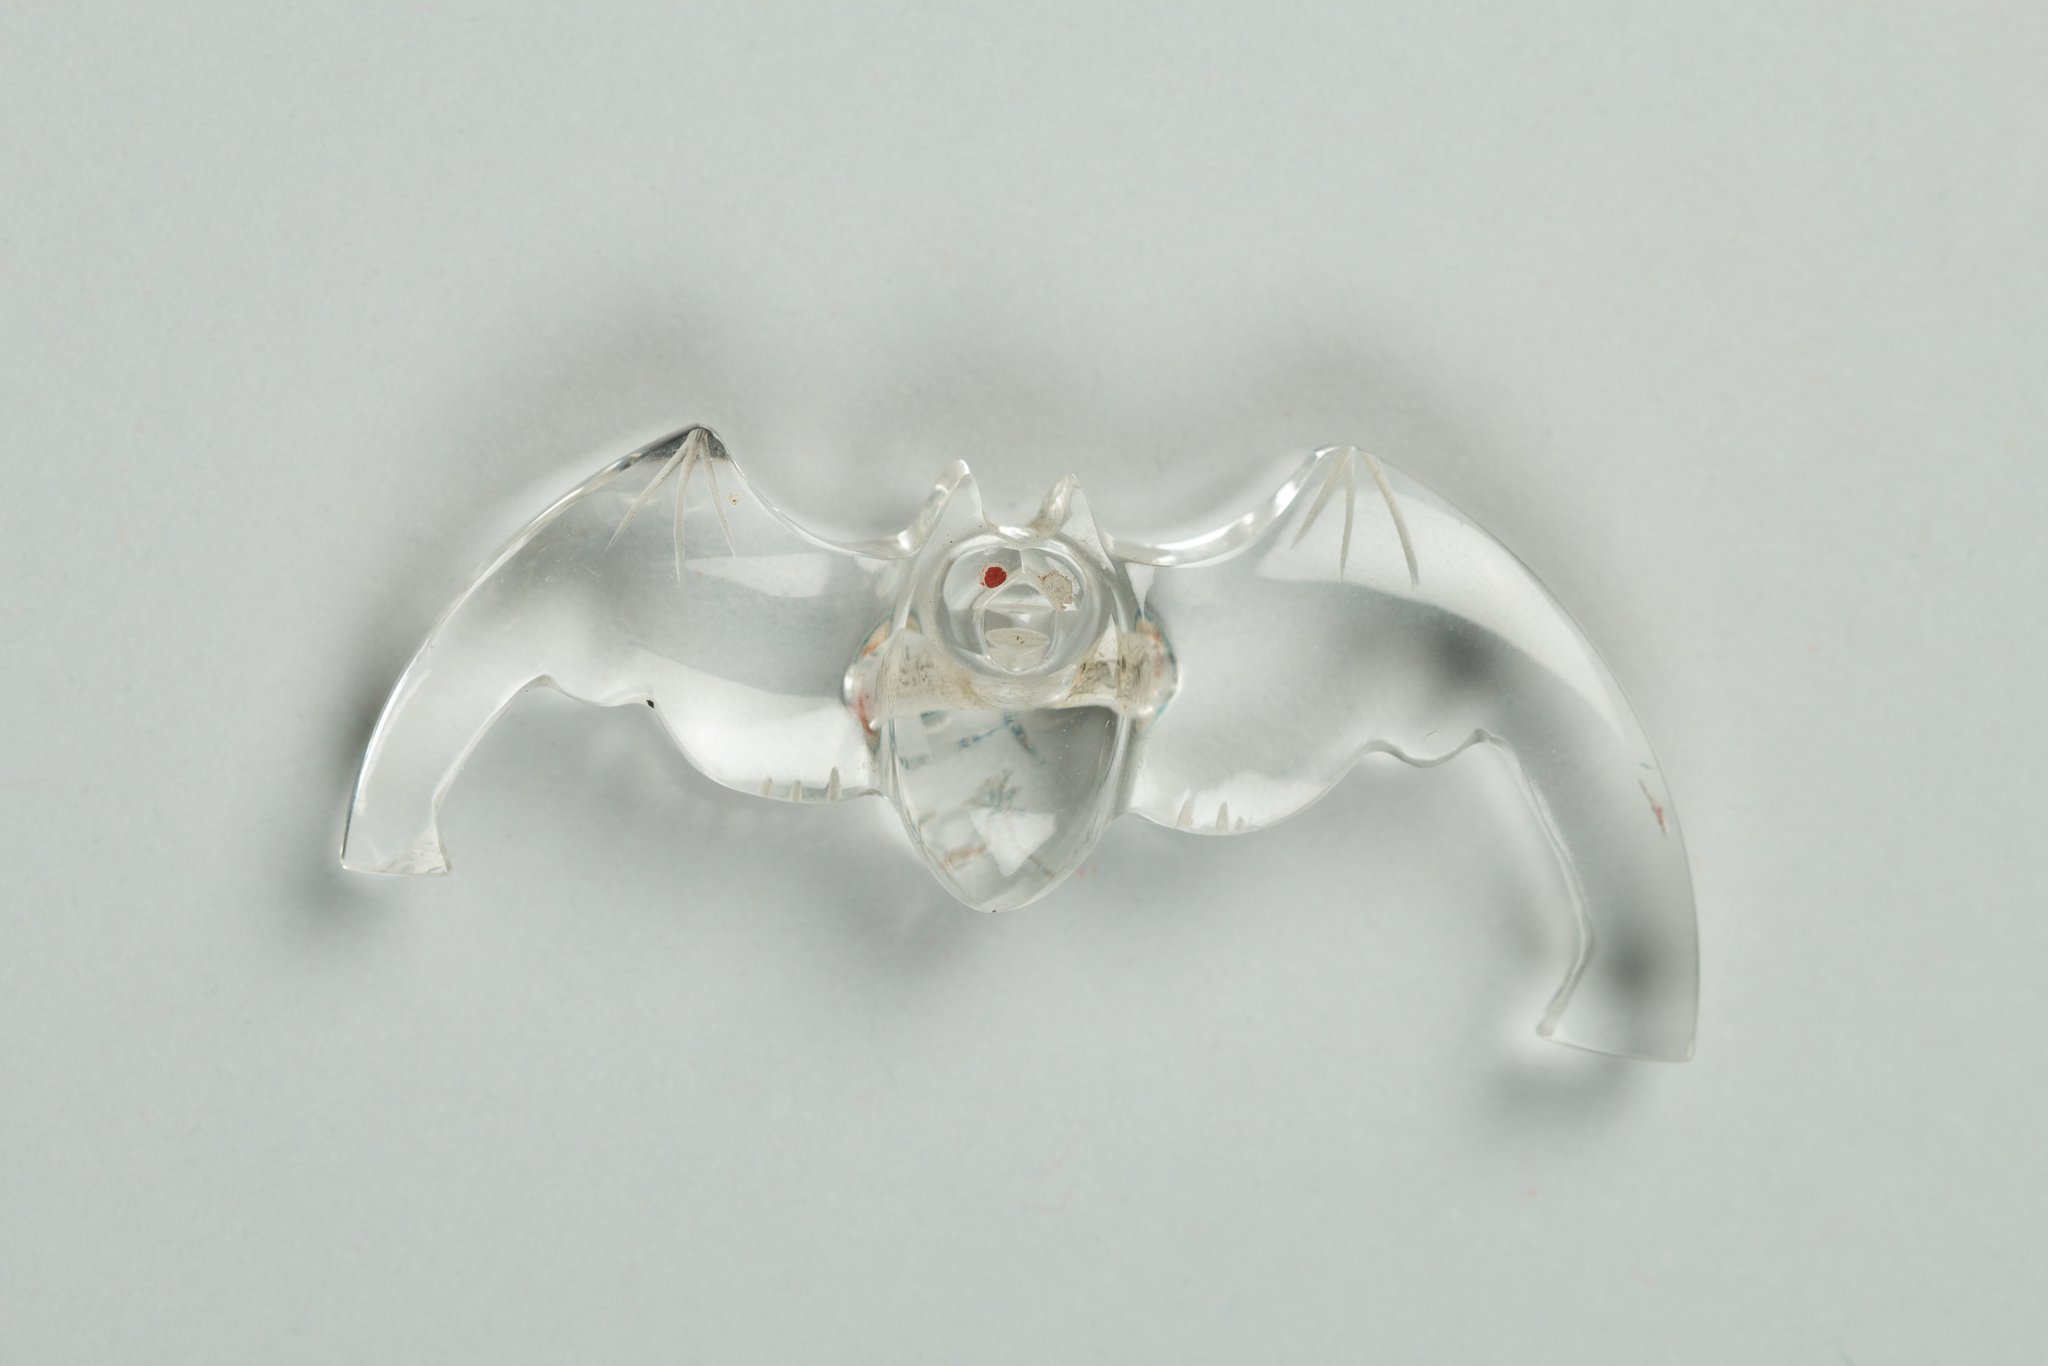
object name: netsuke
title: Netsuke of Bat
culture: japanese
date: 1801-1900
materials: quartz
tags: bats